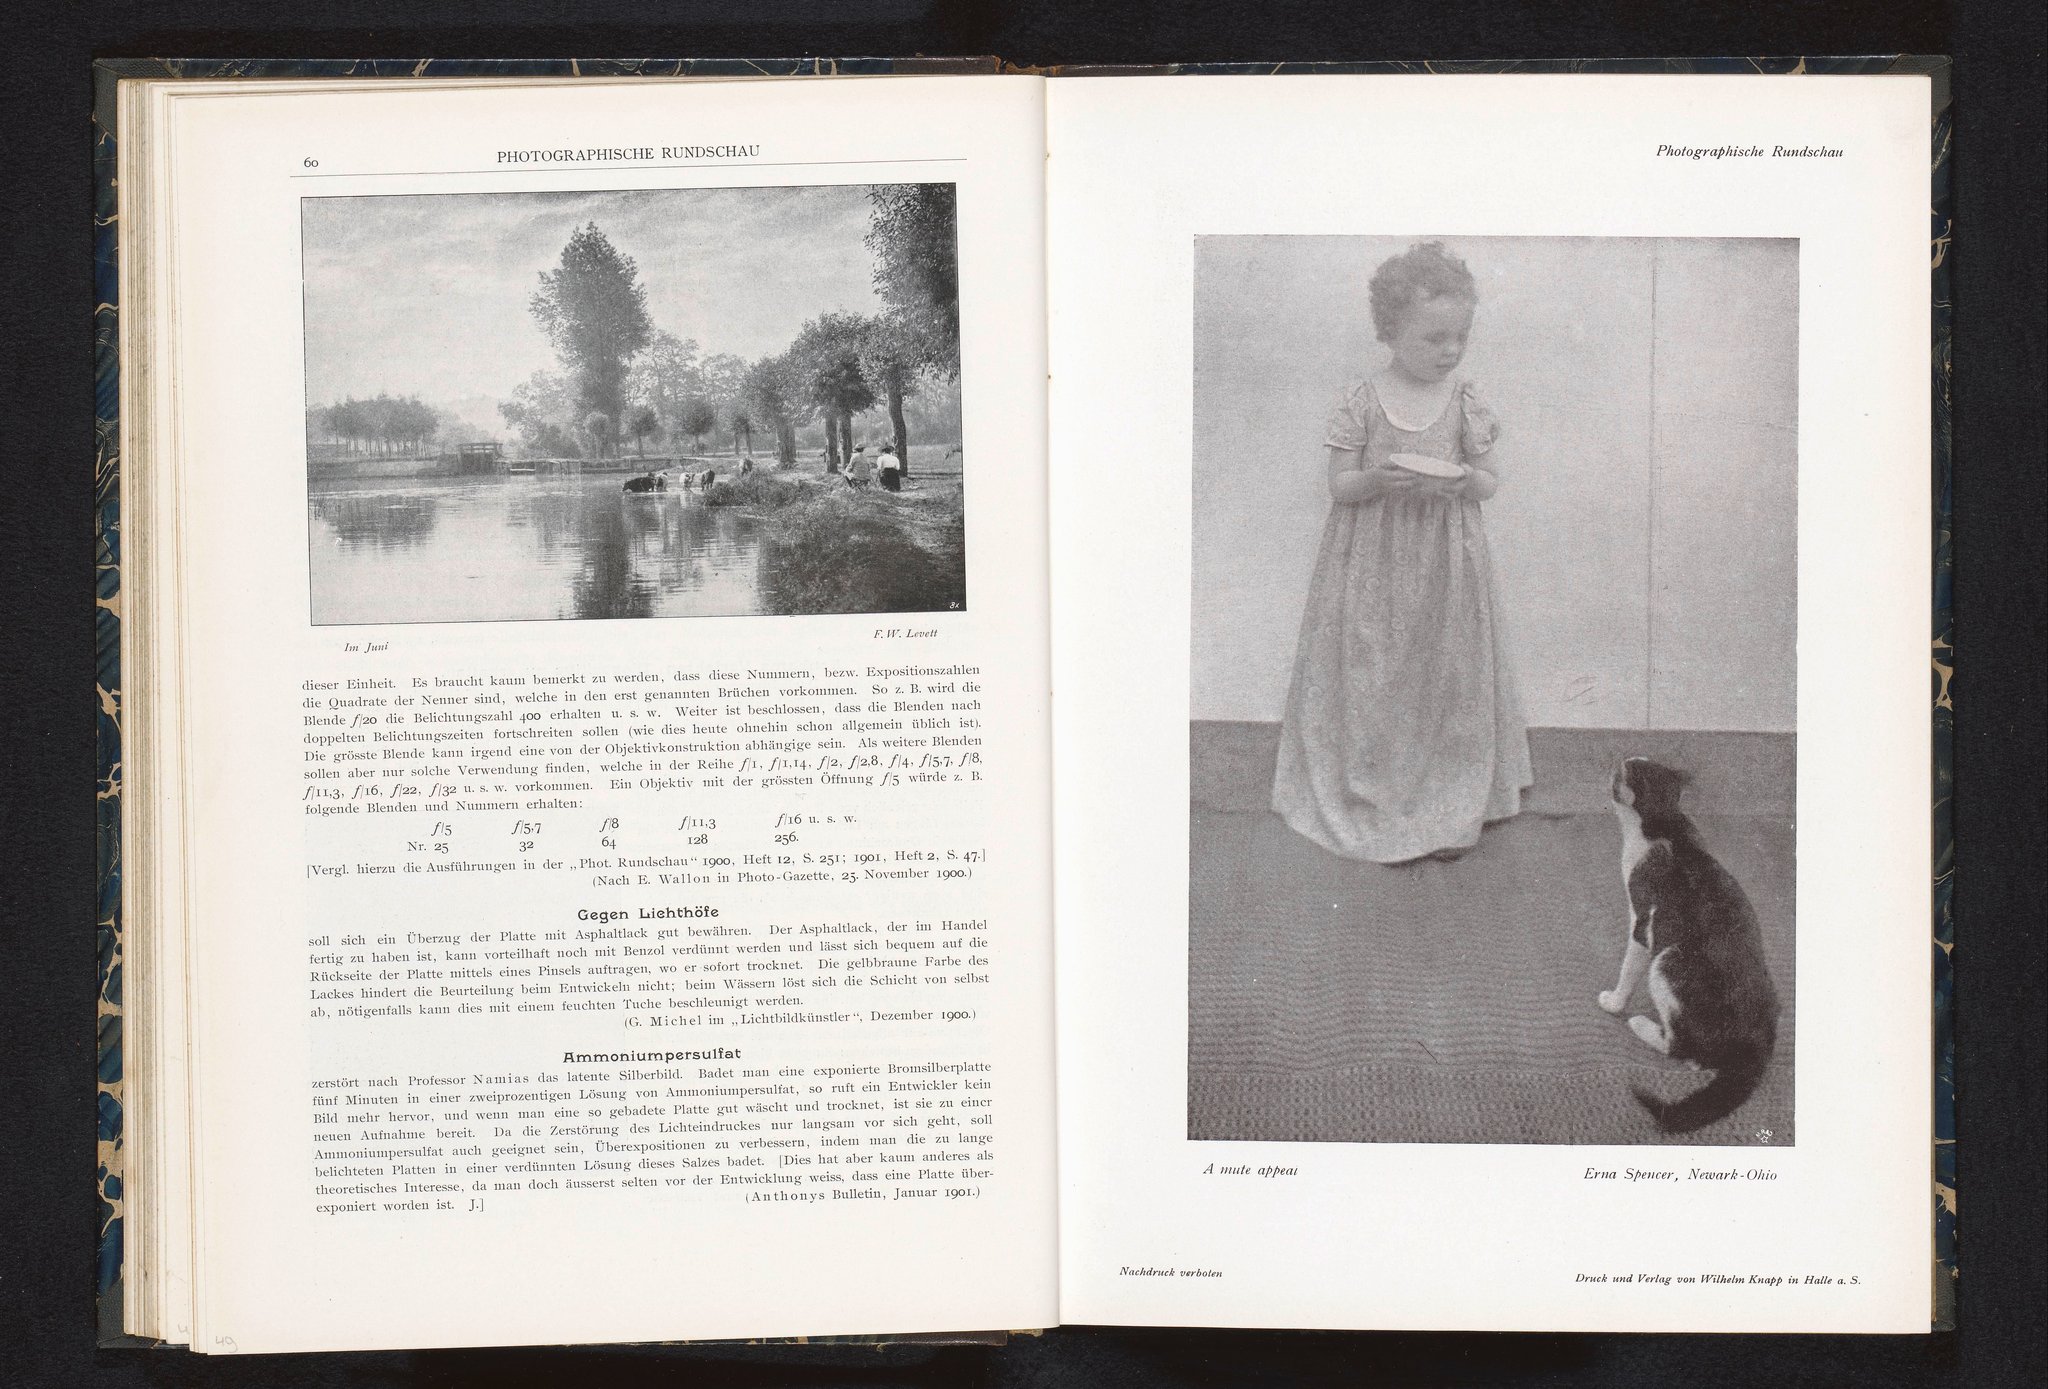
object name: photomechanical print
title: A mute appeal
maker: erna spencer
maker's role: fotograaf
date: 1896-1901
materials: paper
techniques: autotype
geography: berlin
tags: cat, child